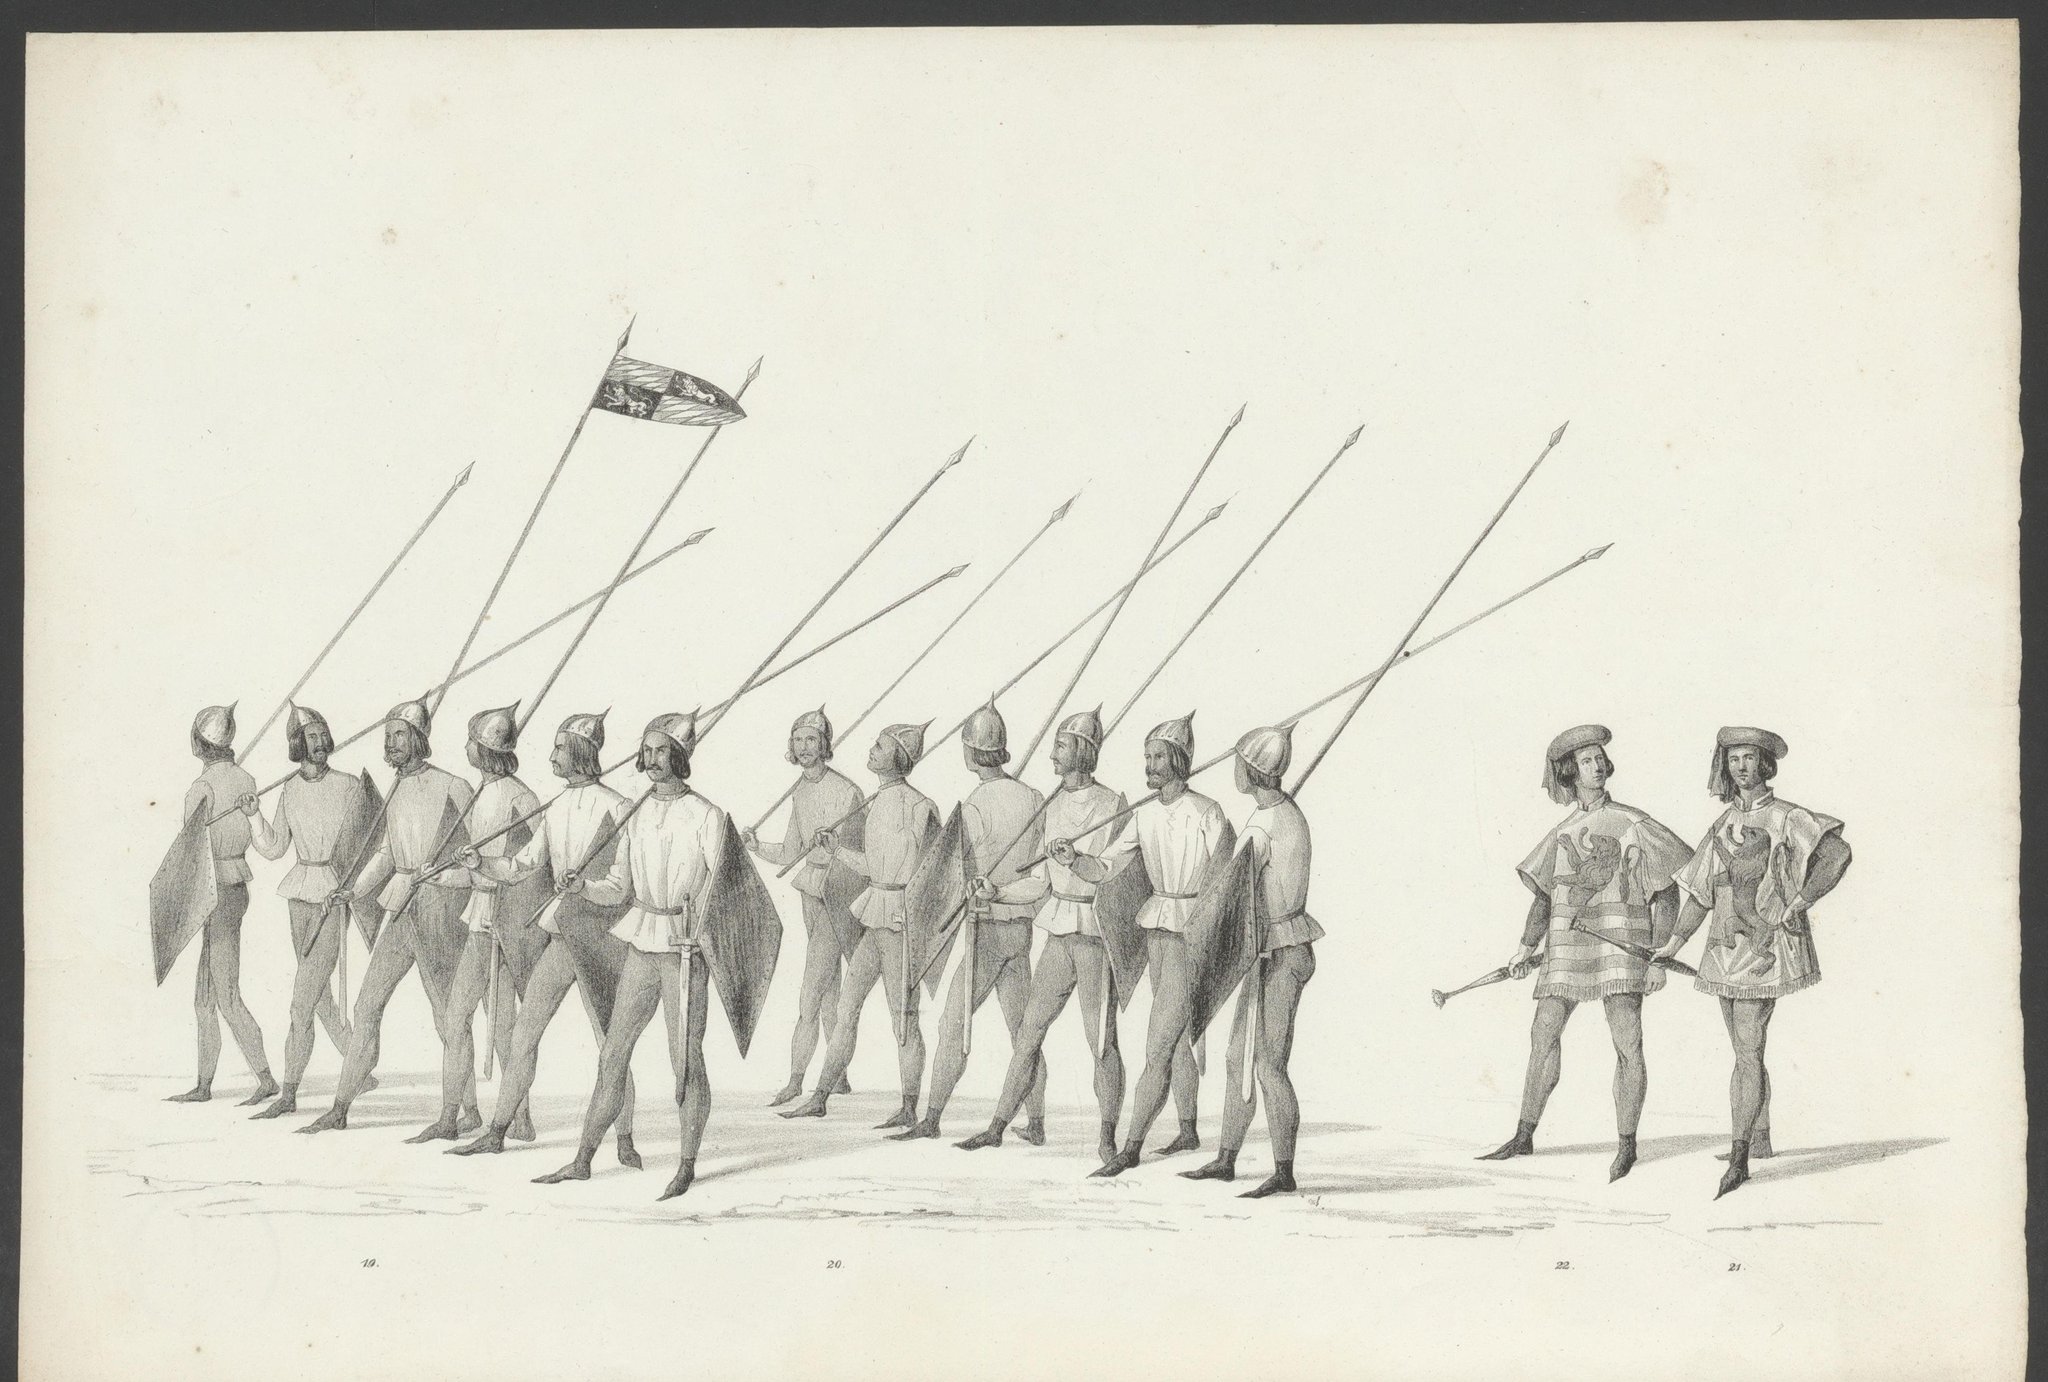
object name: print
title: De intogt van Hertog Jan van Beijeren binnen Leyden. Op den 18den Augustus 1420 in Maskerade voorgesteld door H.H. Studenten der Leydsche Hoogeschool, Op den 8sten Februarij 1840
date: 1840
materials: paper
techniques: lithograph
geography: leiden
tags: jan van beieren, students' pageant, triumphal entry and public reception, pageant, 'entrée solennelle', 'joyeuse entrée'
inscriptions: collector's mark: Lugt 1641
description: Lijfwacht van de hertog. Historische gekostumeerde optocht van de studenten van de Hogeschool van Leiden op 8 februari 1840. De optocht verbeeldt de intocht van hertog Jan van Beieren te Leiden op 18 augustus 1420. Onderaan genummerd: 19 t/m 21. Onderwerpsrubrieken binnen de Atlas Zeden en Gewoonten: Onderwijs en Wetenschappen, Studentenleven.